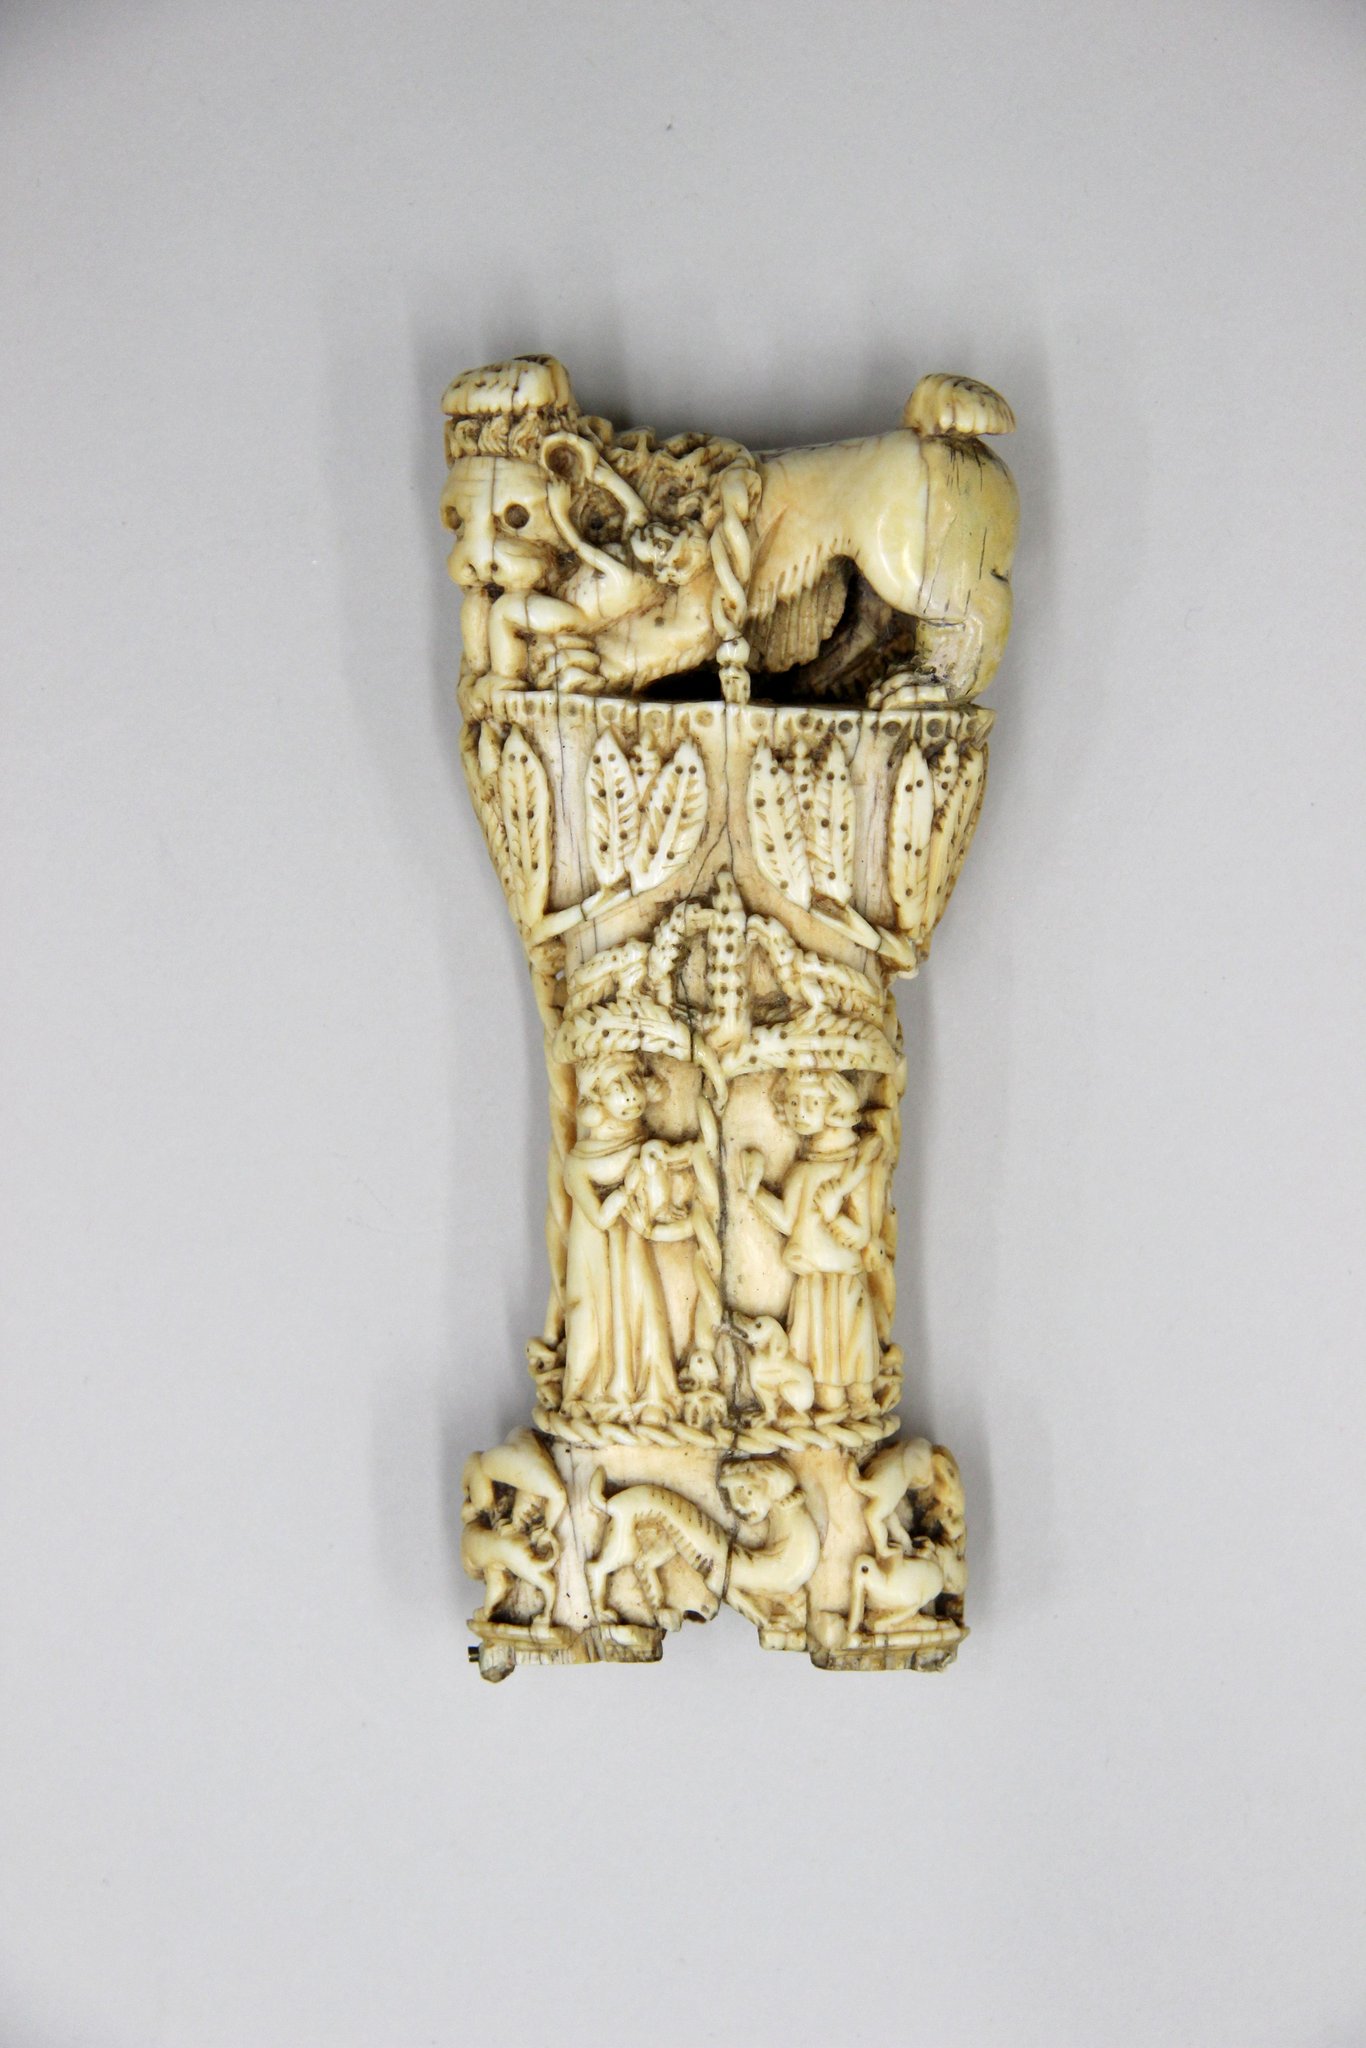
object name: dagger grip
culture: italian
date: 1400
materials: ivory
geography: italy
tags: animals